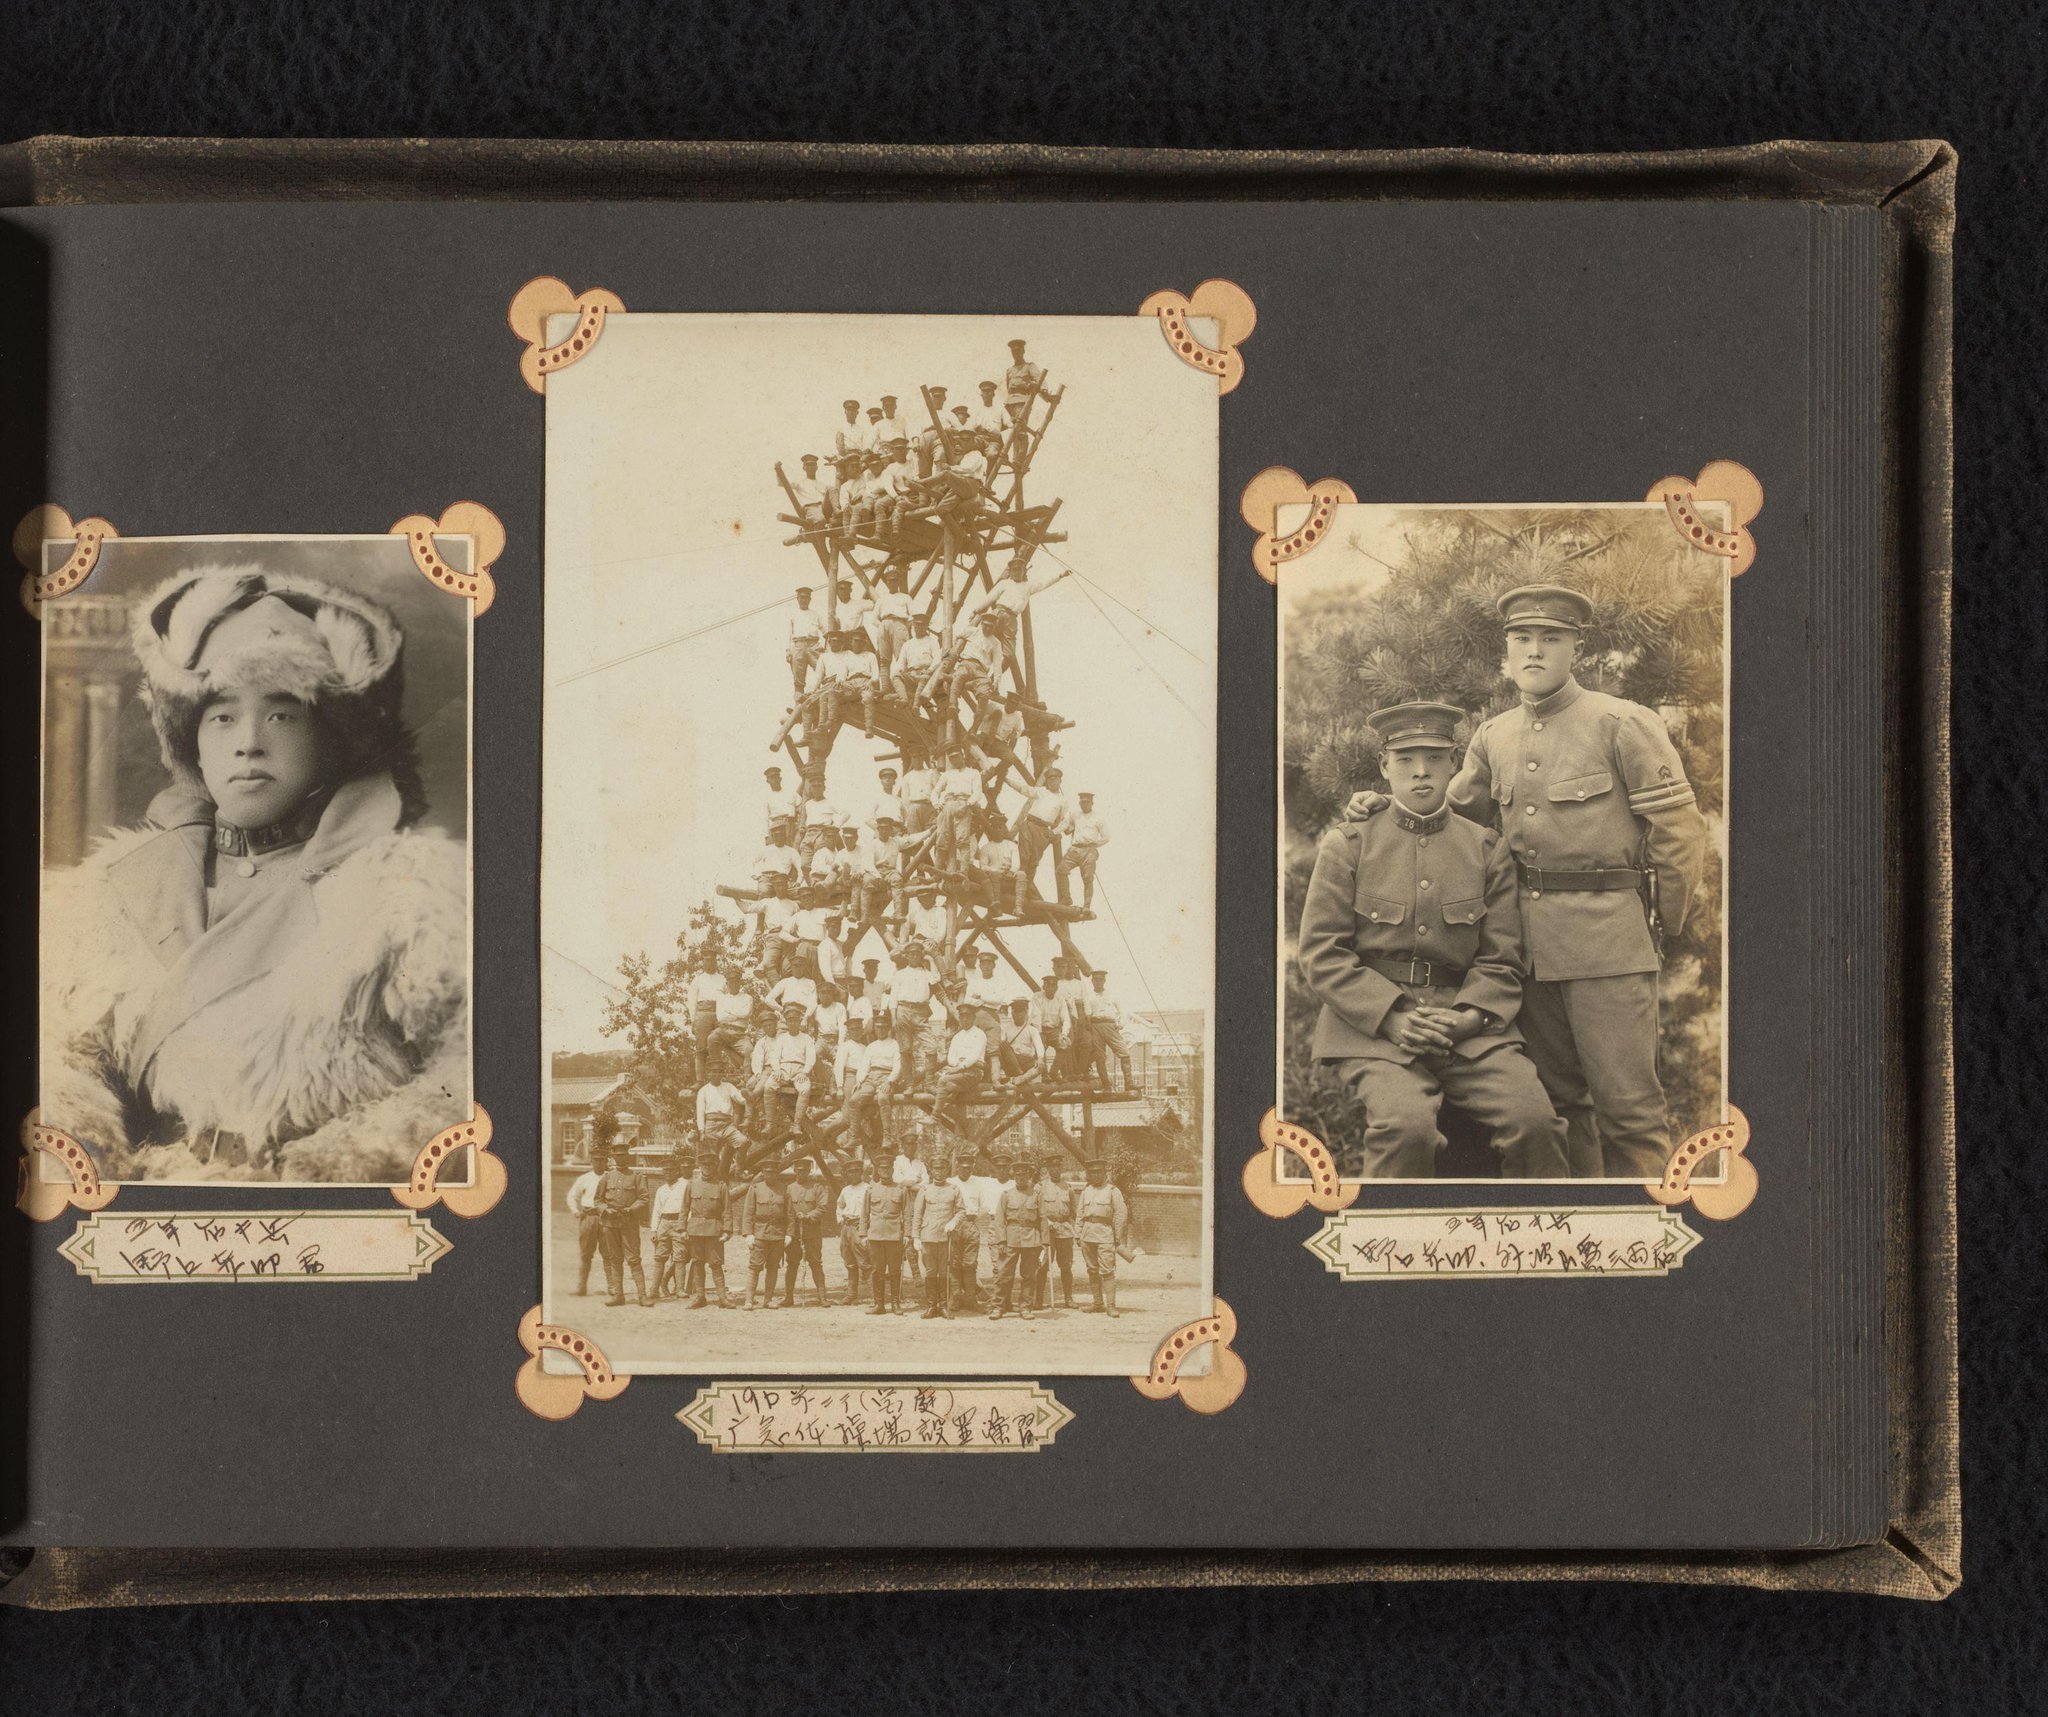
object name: album leaf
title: Drie portretten van onbekende Japanse soldaten, in het midden een groepsportret rond een houten steiger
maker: Anonymous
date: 1930-1940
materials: paper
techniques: gelatin silver print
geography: korea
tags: anonymous historical person portrayed, the soldier; the soldier's life, anonymous historical persons portrayed in a group, in a group-portrait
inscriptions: inscription: ‘[...]’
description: Deze foto's zijn onderdeel van een album.